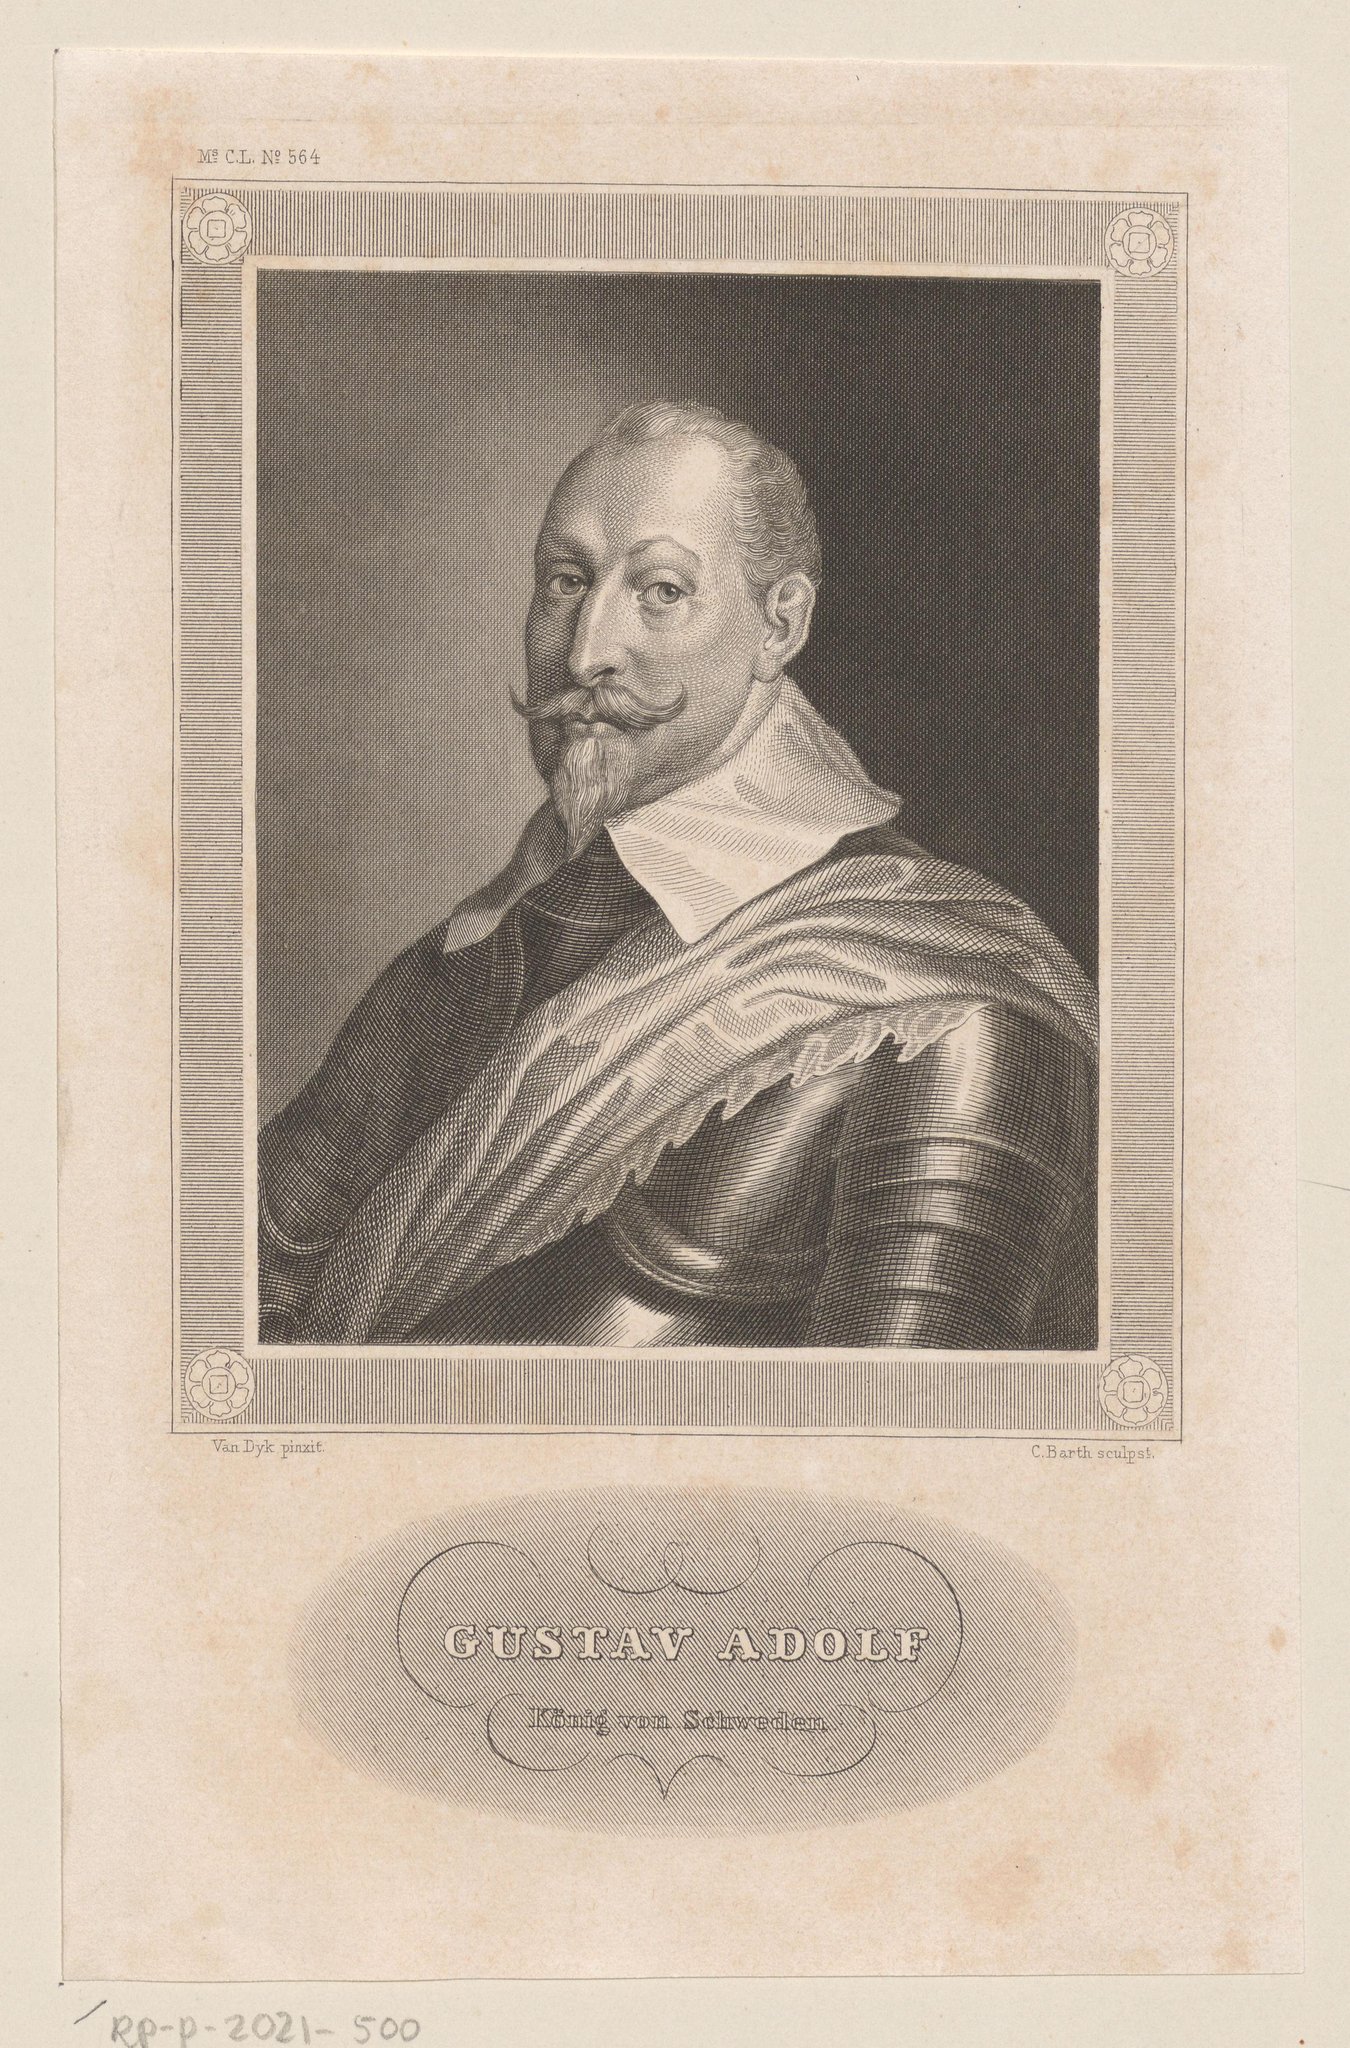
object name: book illustration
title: Portret van Gustaaf II, koning van Zweden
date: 1828-1852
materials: paper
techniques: engraving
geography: hildburghausen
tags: historical persons, memorial medal, king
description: Prent uit: Meyer, Joseph. Das große Conversations-Lexikon für die gebildeten Stände. 52 dln. Hildburghausen: Bibliographisches Institut, [1828-1852].